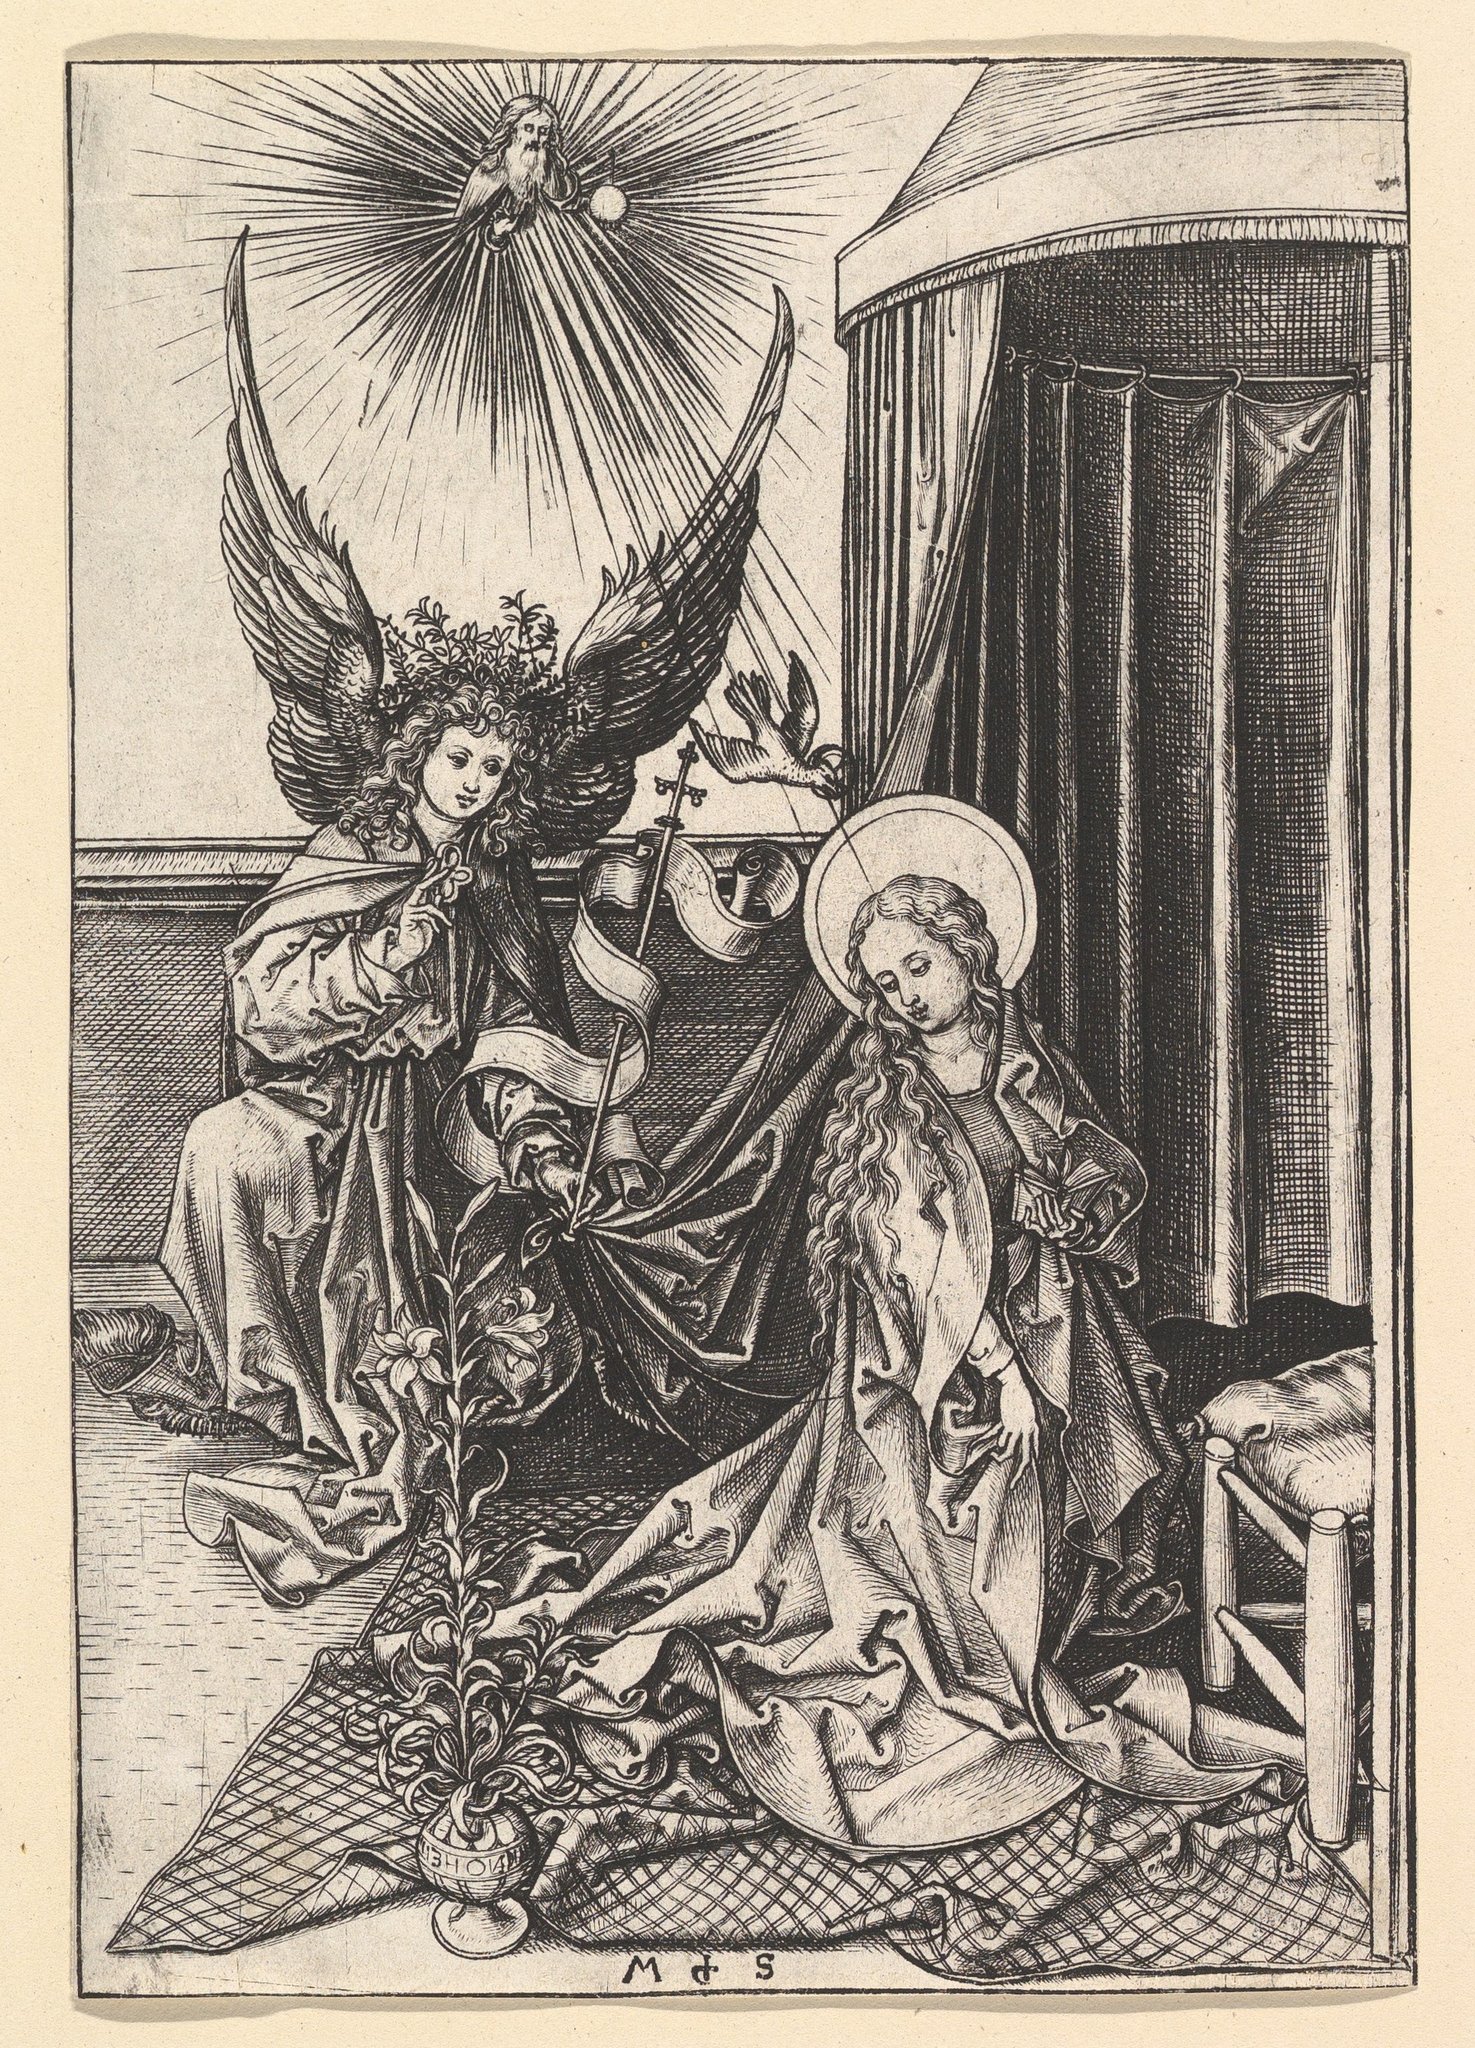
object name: print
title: The Annunciation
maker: martin schongauer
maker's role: artist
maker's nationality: german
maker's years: 1430-1491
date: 1475-1482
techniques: engraving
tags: annunciation